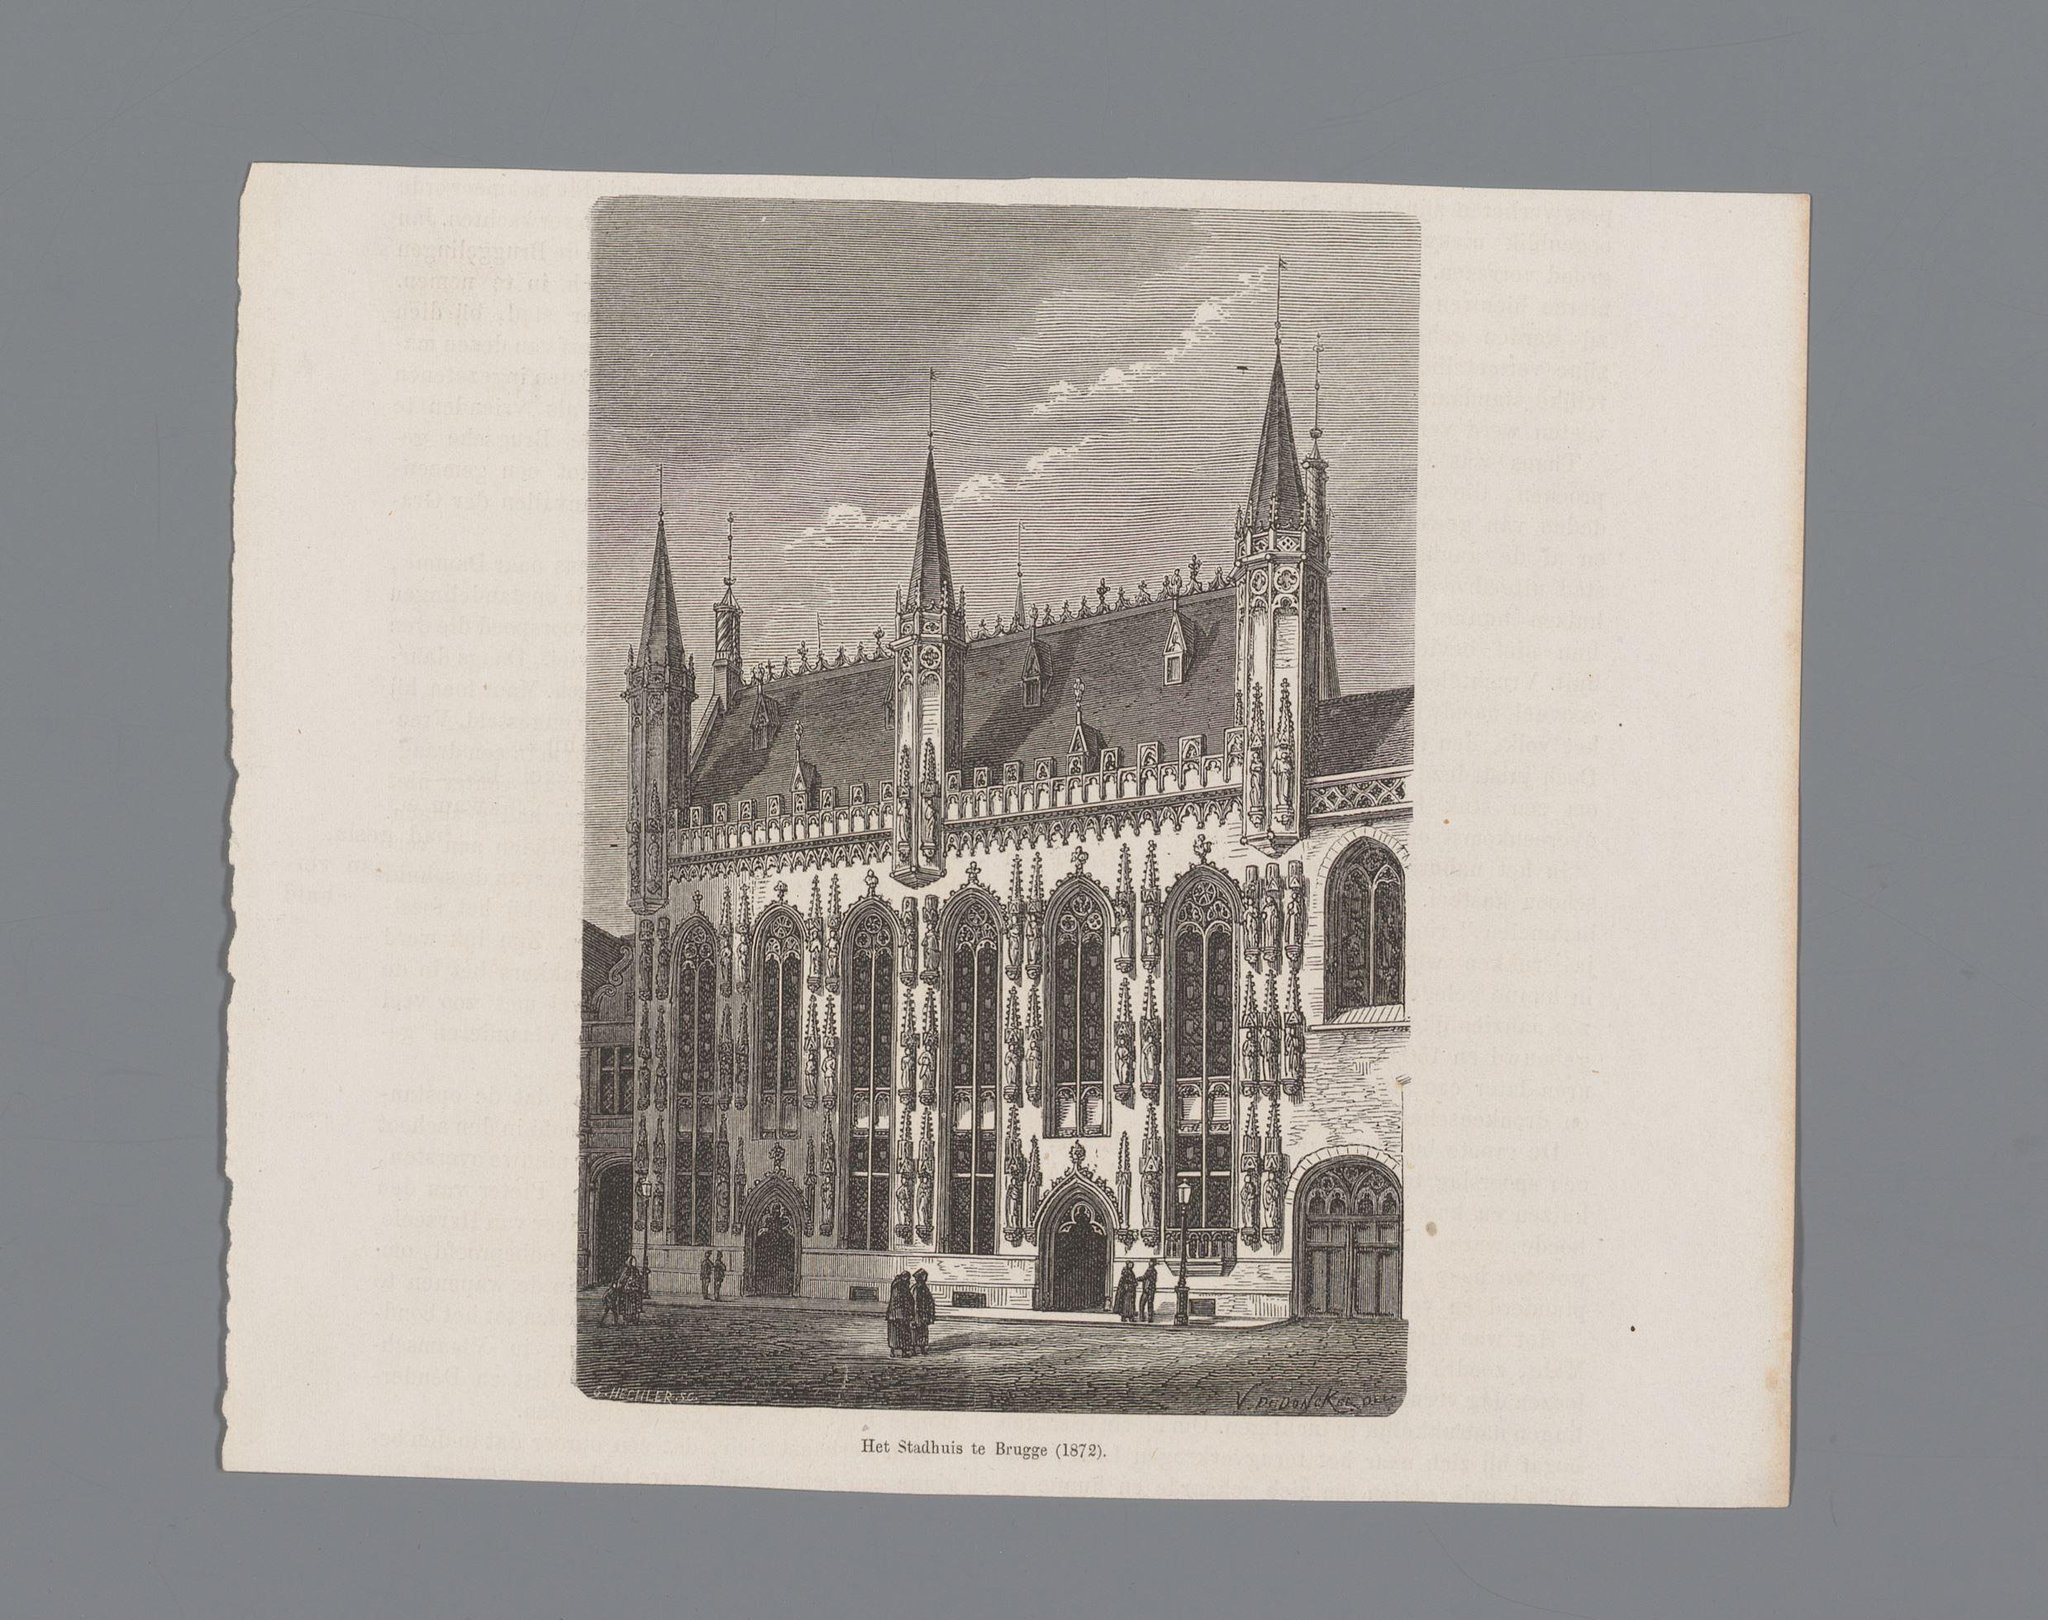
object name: book illustration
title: Het Stadhuis te Brugge (1872)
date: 1873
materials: paper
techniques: letterpress printing, engraving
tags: townhall, bruges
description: Prent uit: Witkamp, Pieter Harme. Geschiedenis der zeventien Nederlanden. S.l.: Van Bakkenes, 1873, dl. 1, p. 633.